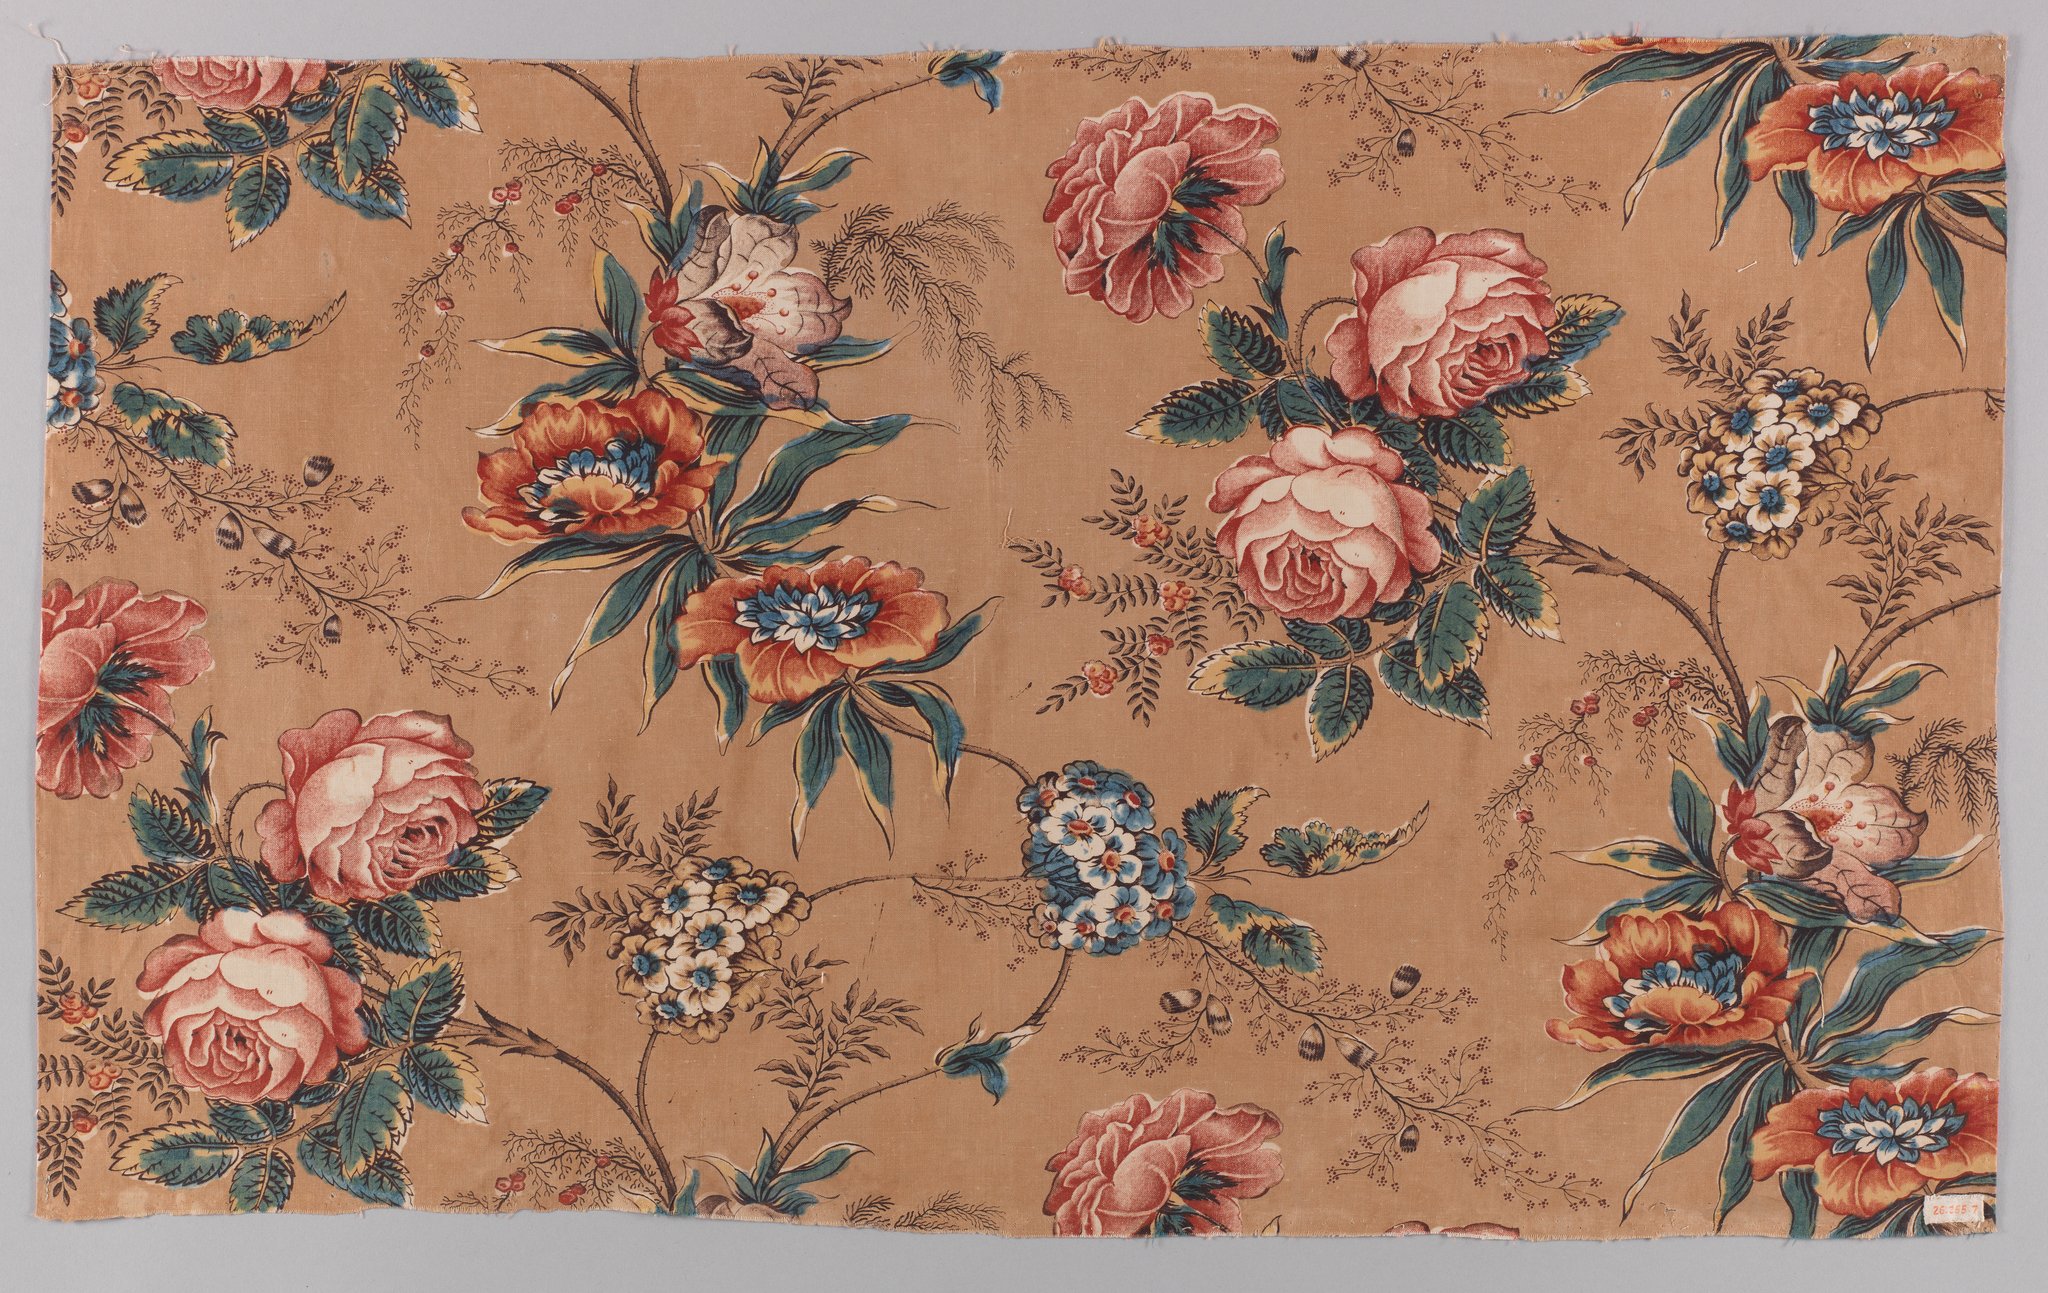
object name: piece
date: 1830-1835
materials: cotton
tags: roses